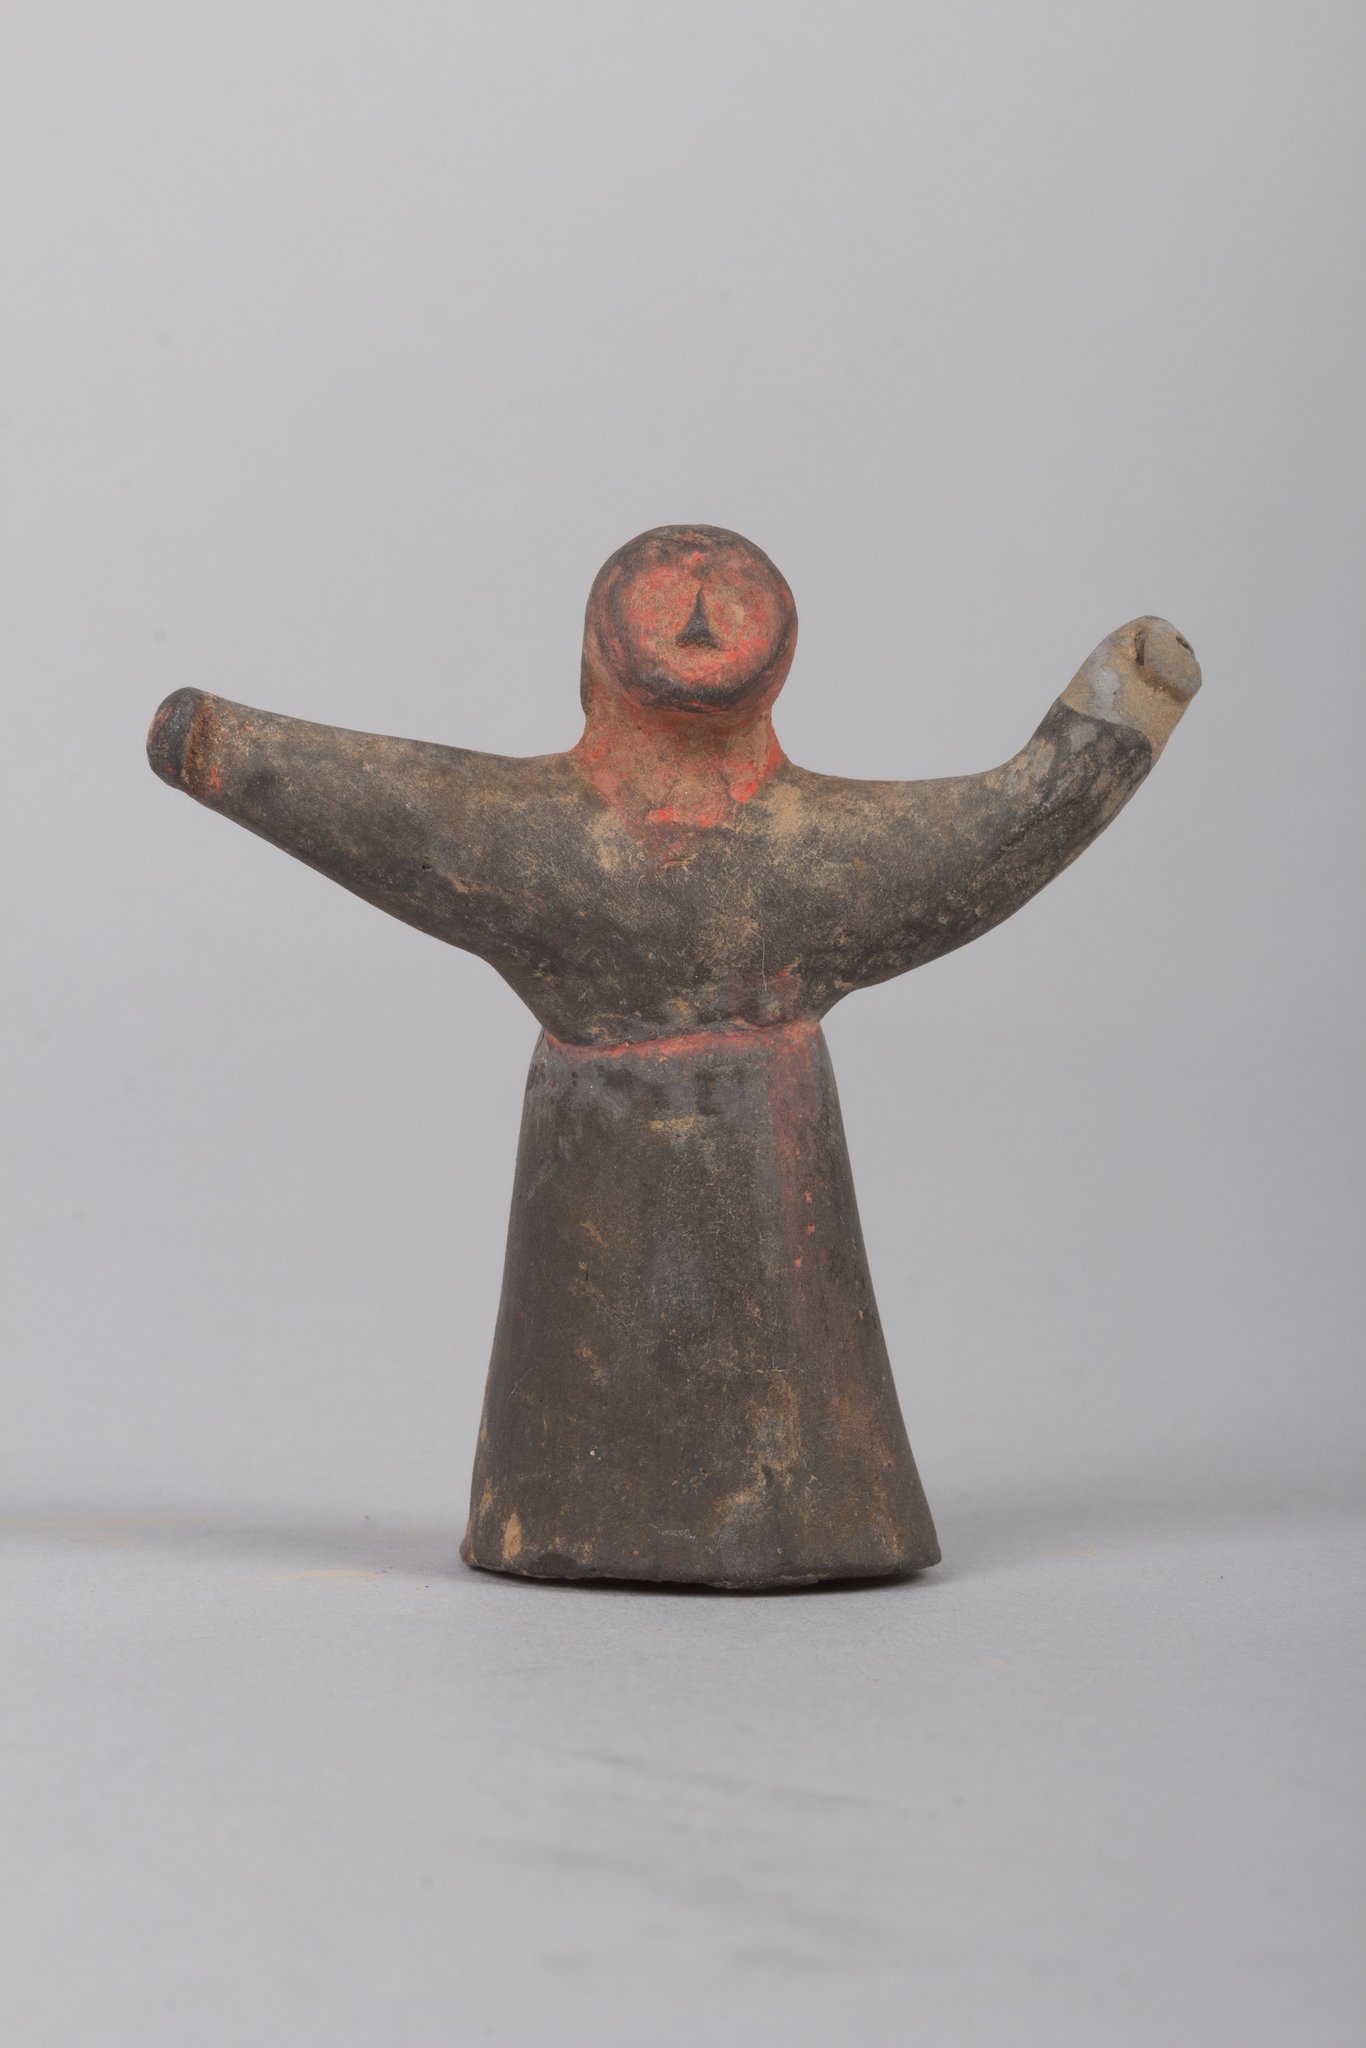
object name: figure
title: Figure of a woman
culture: chinese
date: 400-201 BCE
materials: clay